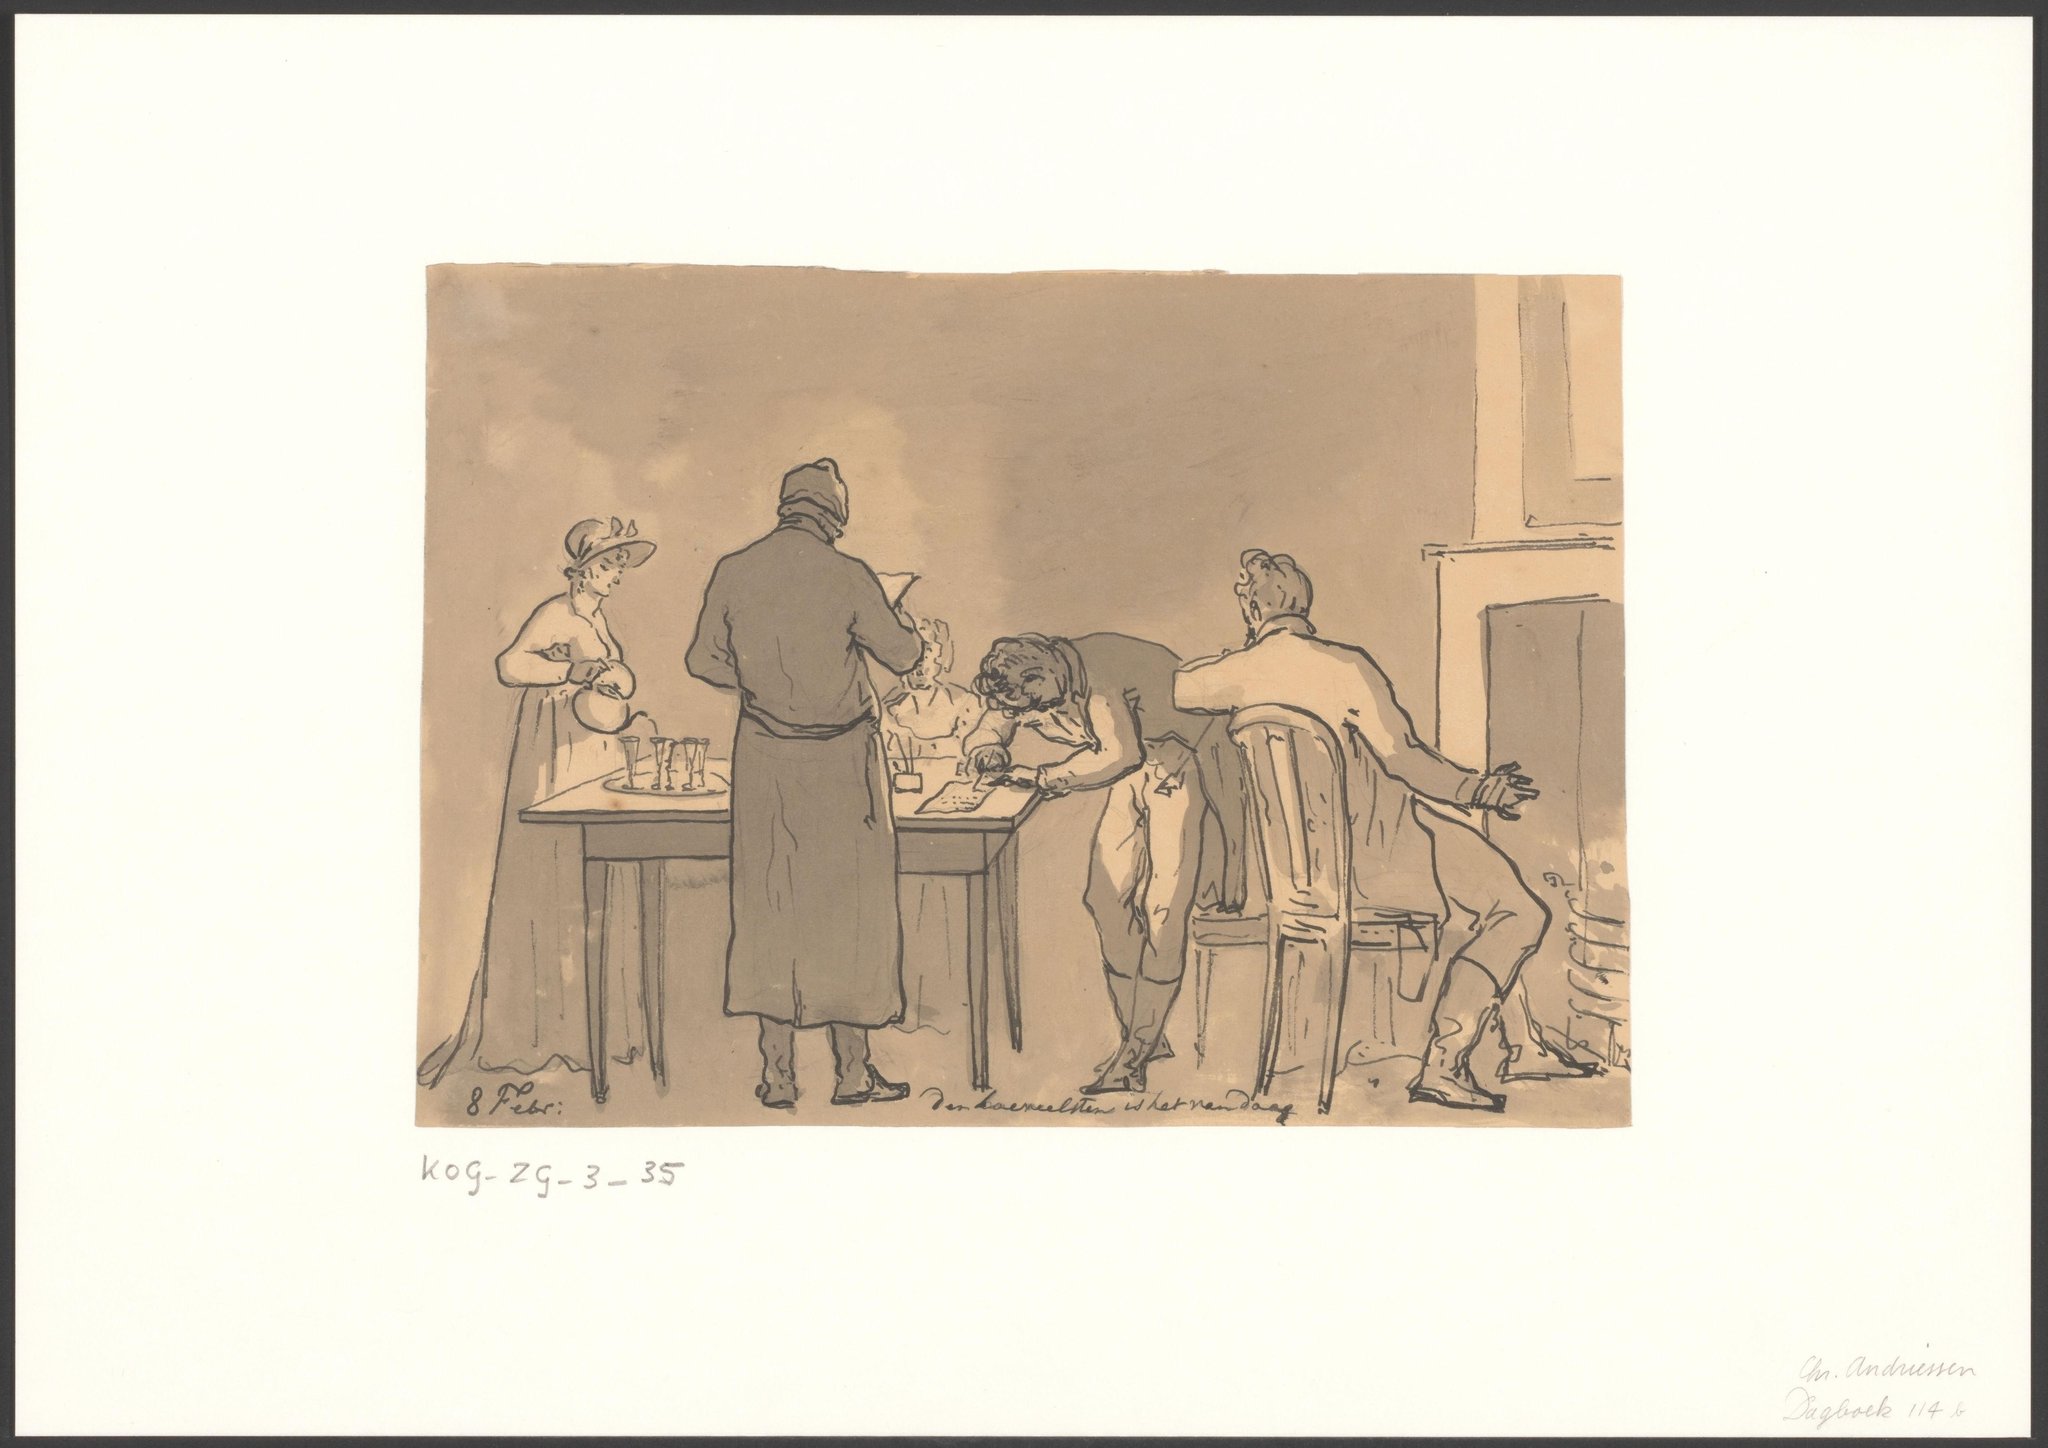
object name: drawing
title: Drie mannen en twee vrouwen in een kamer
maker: christiaan andriessen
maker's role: draughtsman, print maker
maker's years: 1775-1846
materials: ink, paper, pencil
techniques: brush, pen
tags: pouring, living-room, parlour, sitting-room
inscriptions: inscription: ‘J Andriessen’, inscription: ‘8 Febr den hoeveelsten is het vandaag’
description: Drie mannen en twee vrouwen in een kamer. Een vrouw schenkt drank in en man schrijft voorovergebogen op een blad op tafel.